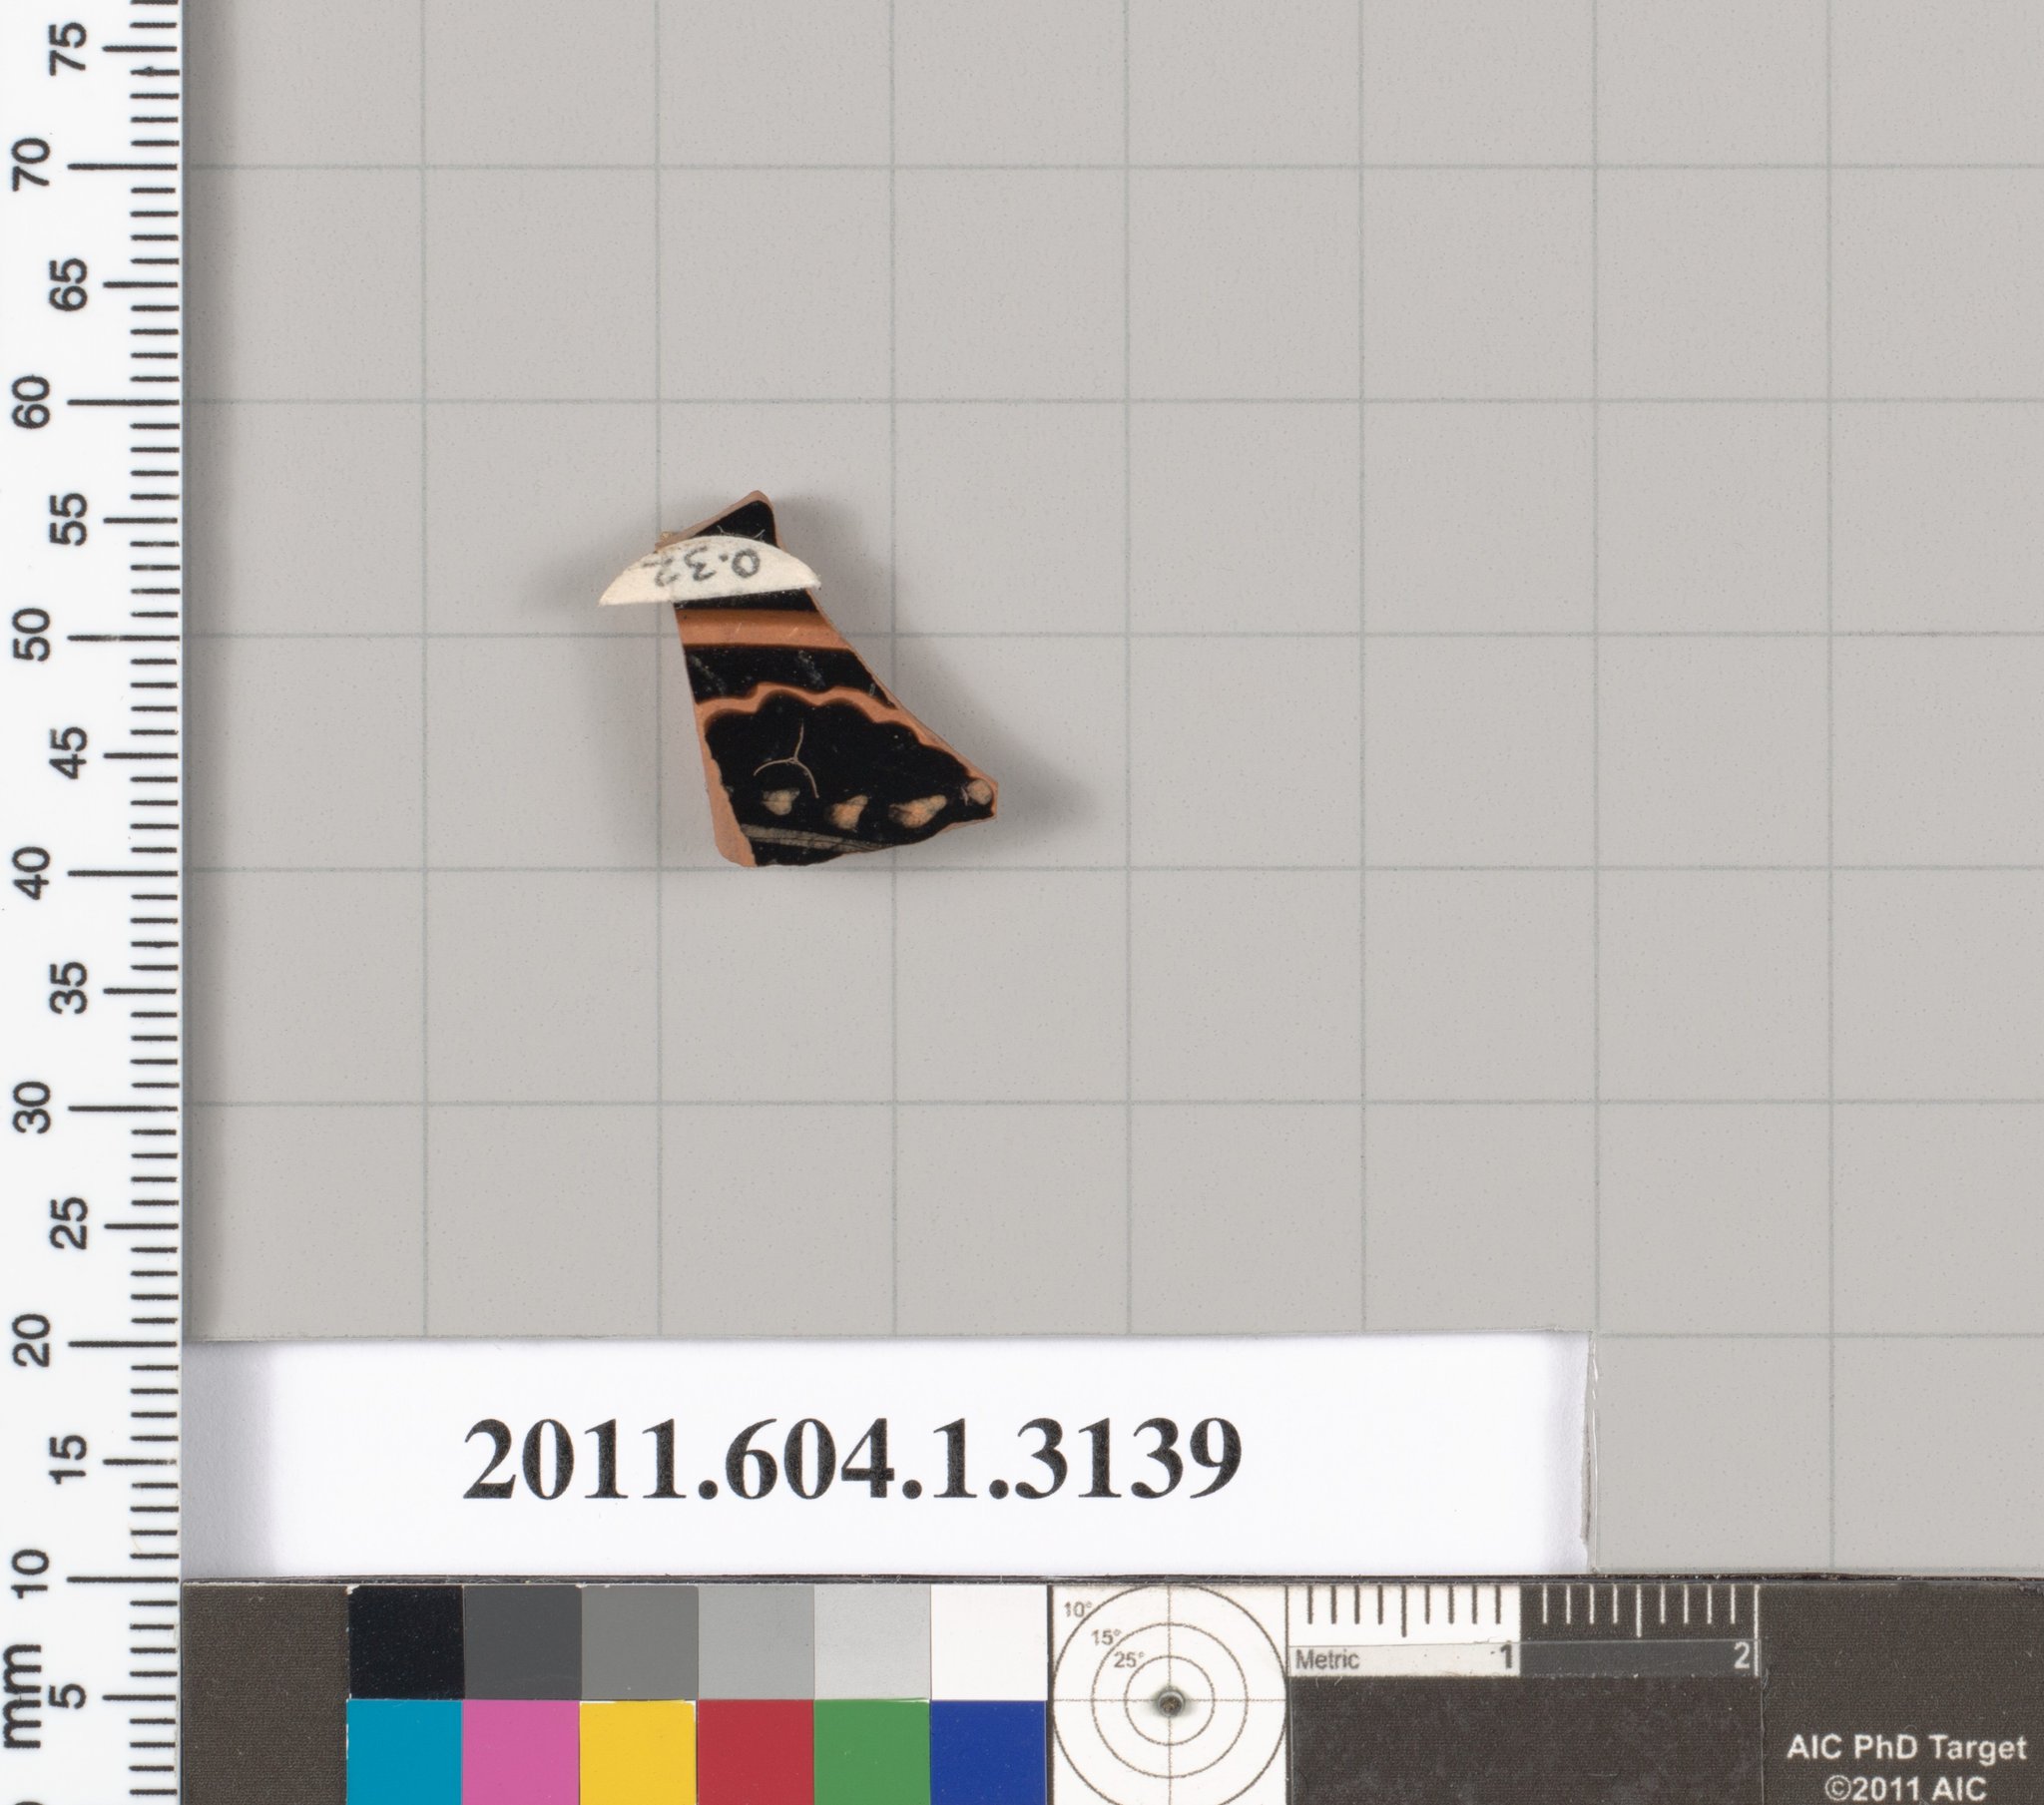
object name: kylix fragment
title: Terracotta fragment of a kylix (drinking cup)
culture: greek, attic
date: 510-490 BCE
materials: terracotta